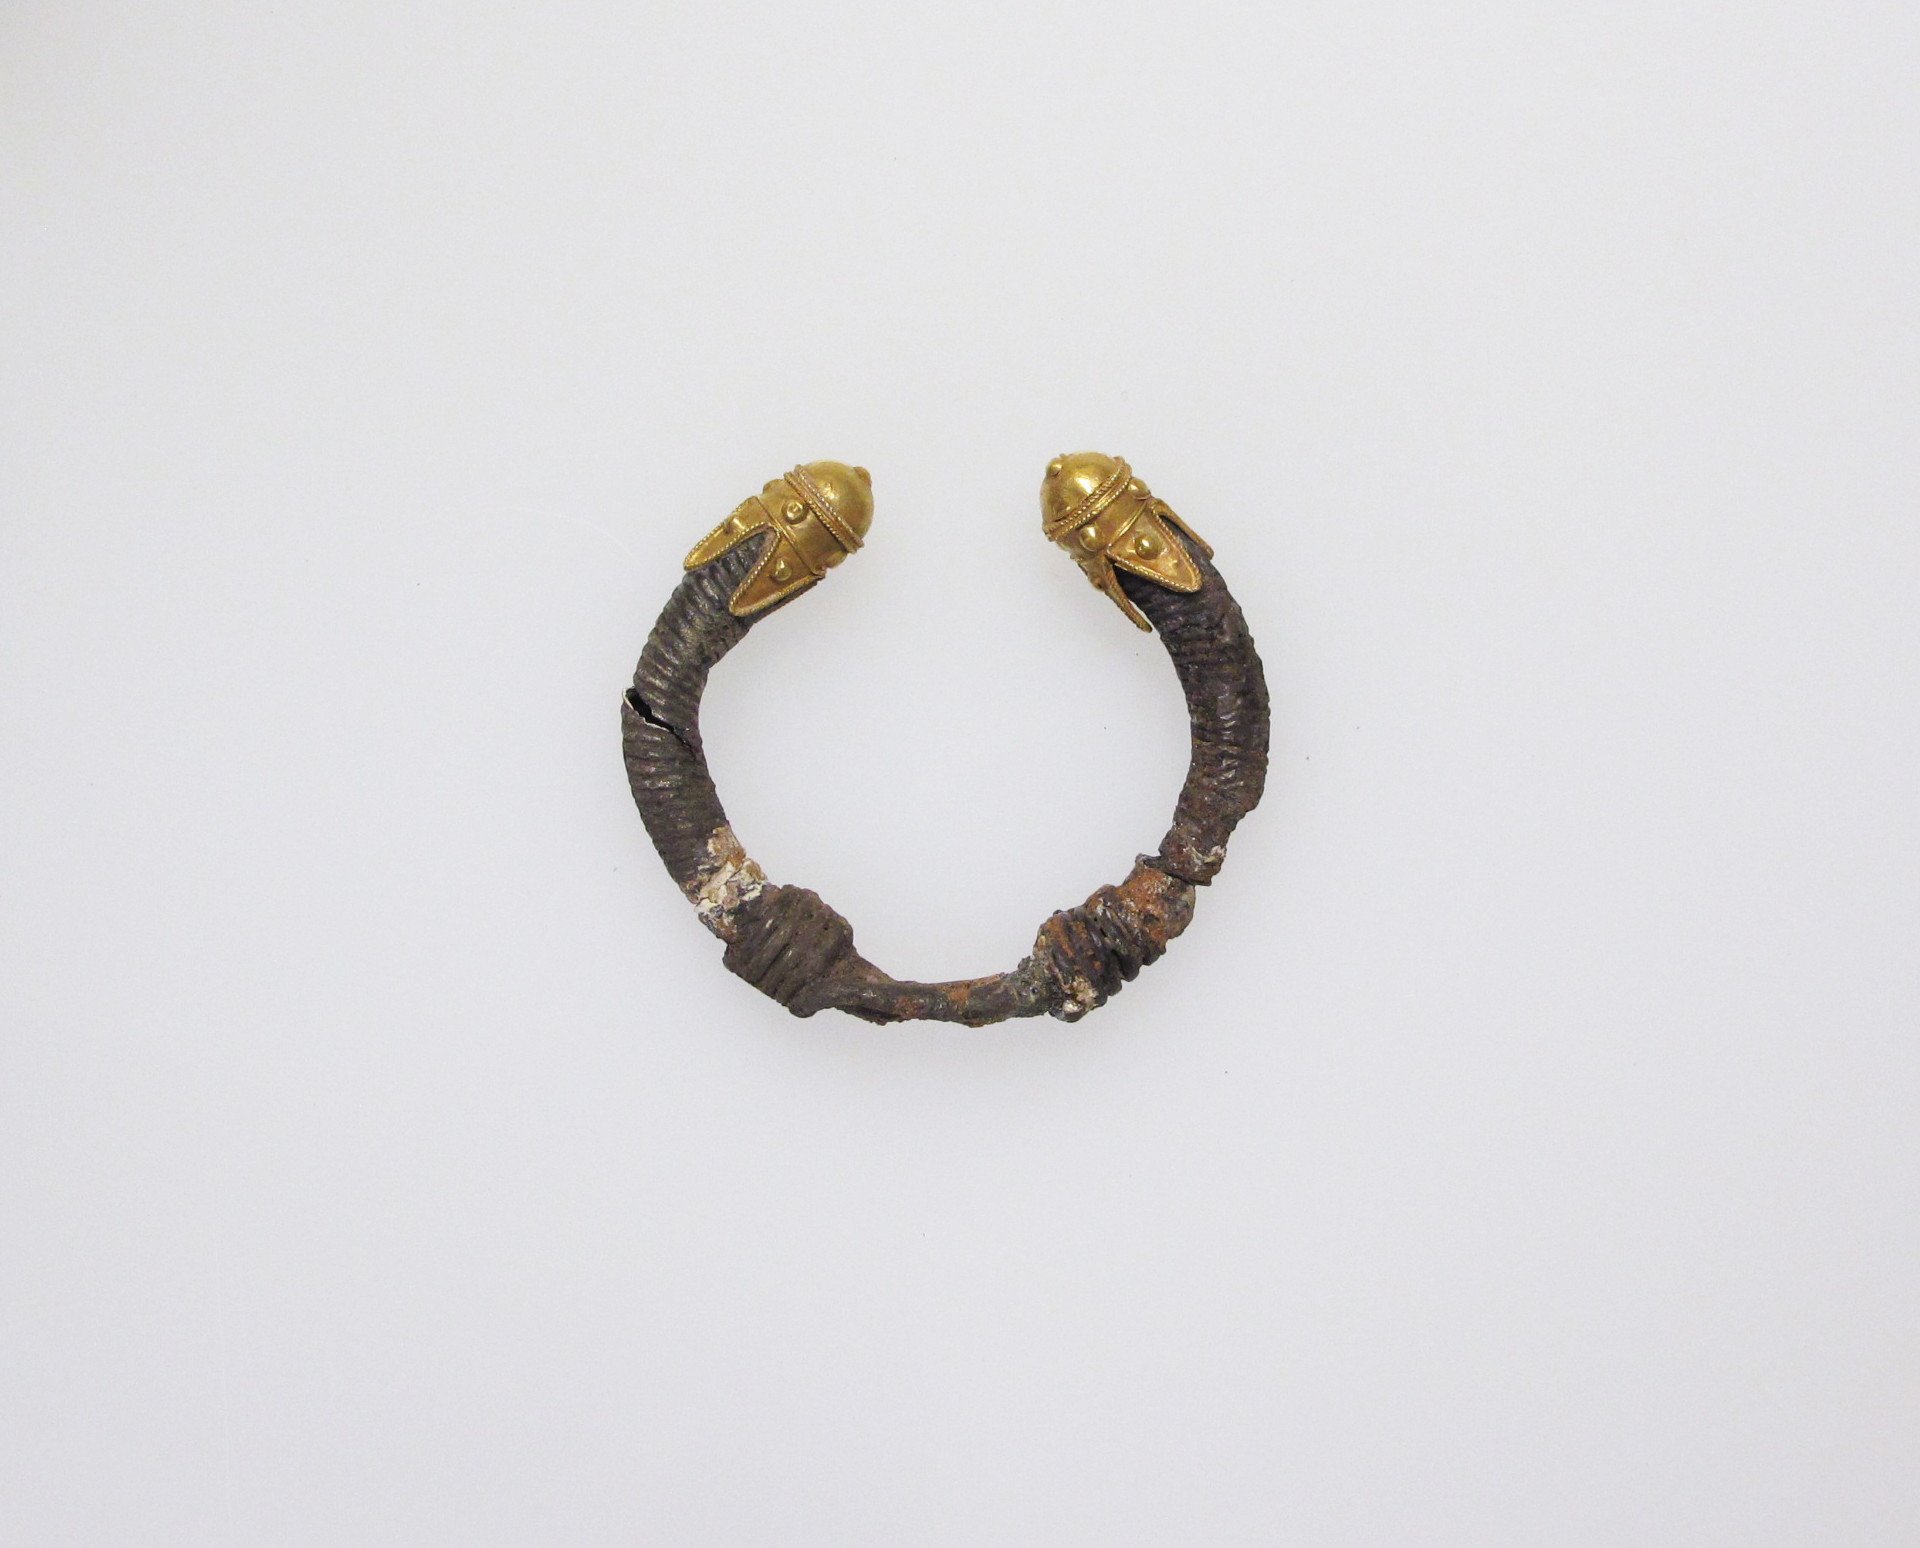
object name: bracelet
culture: greek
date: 600-501 BCE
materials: gold, silver